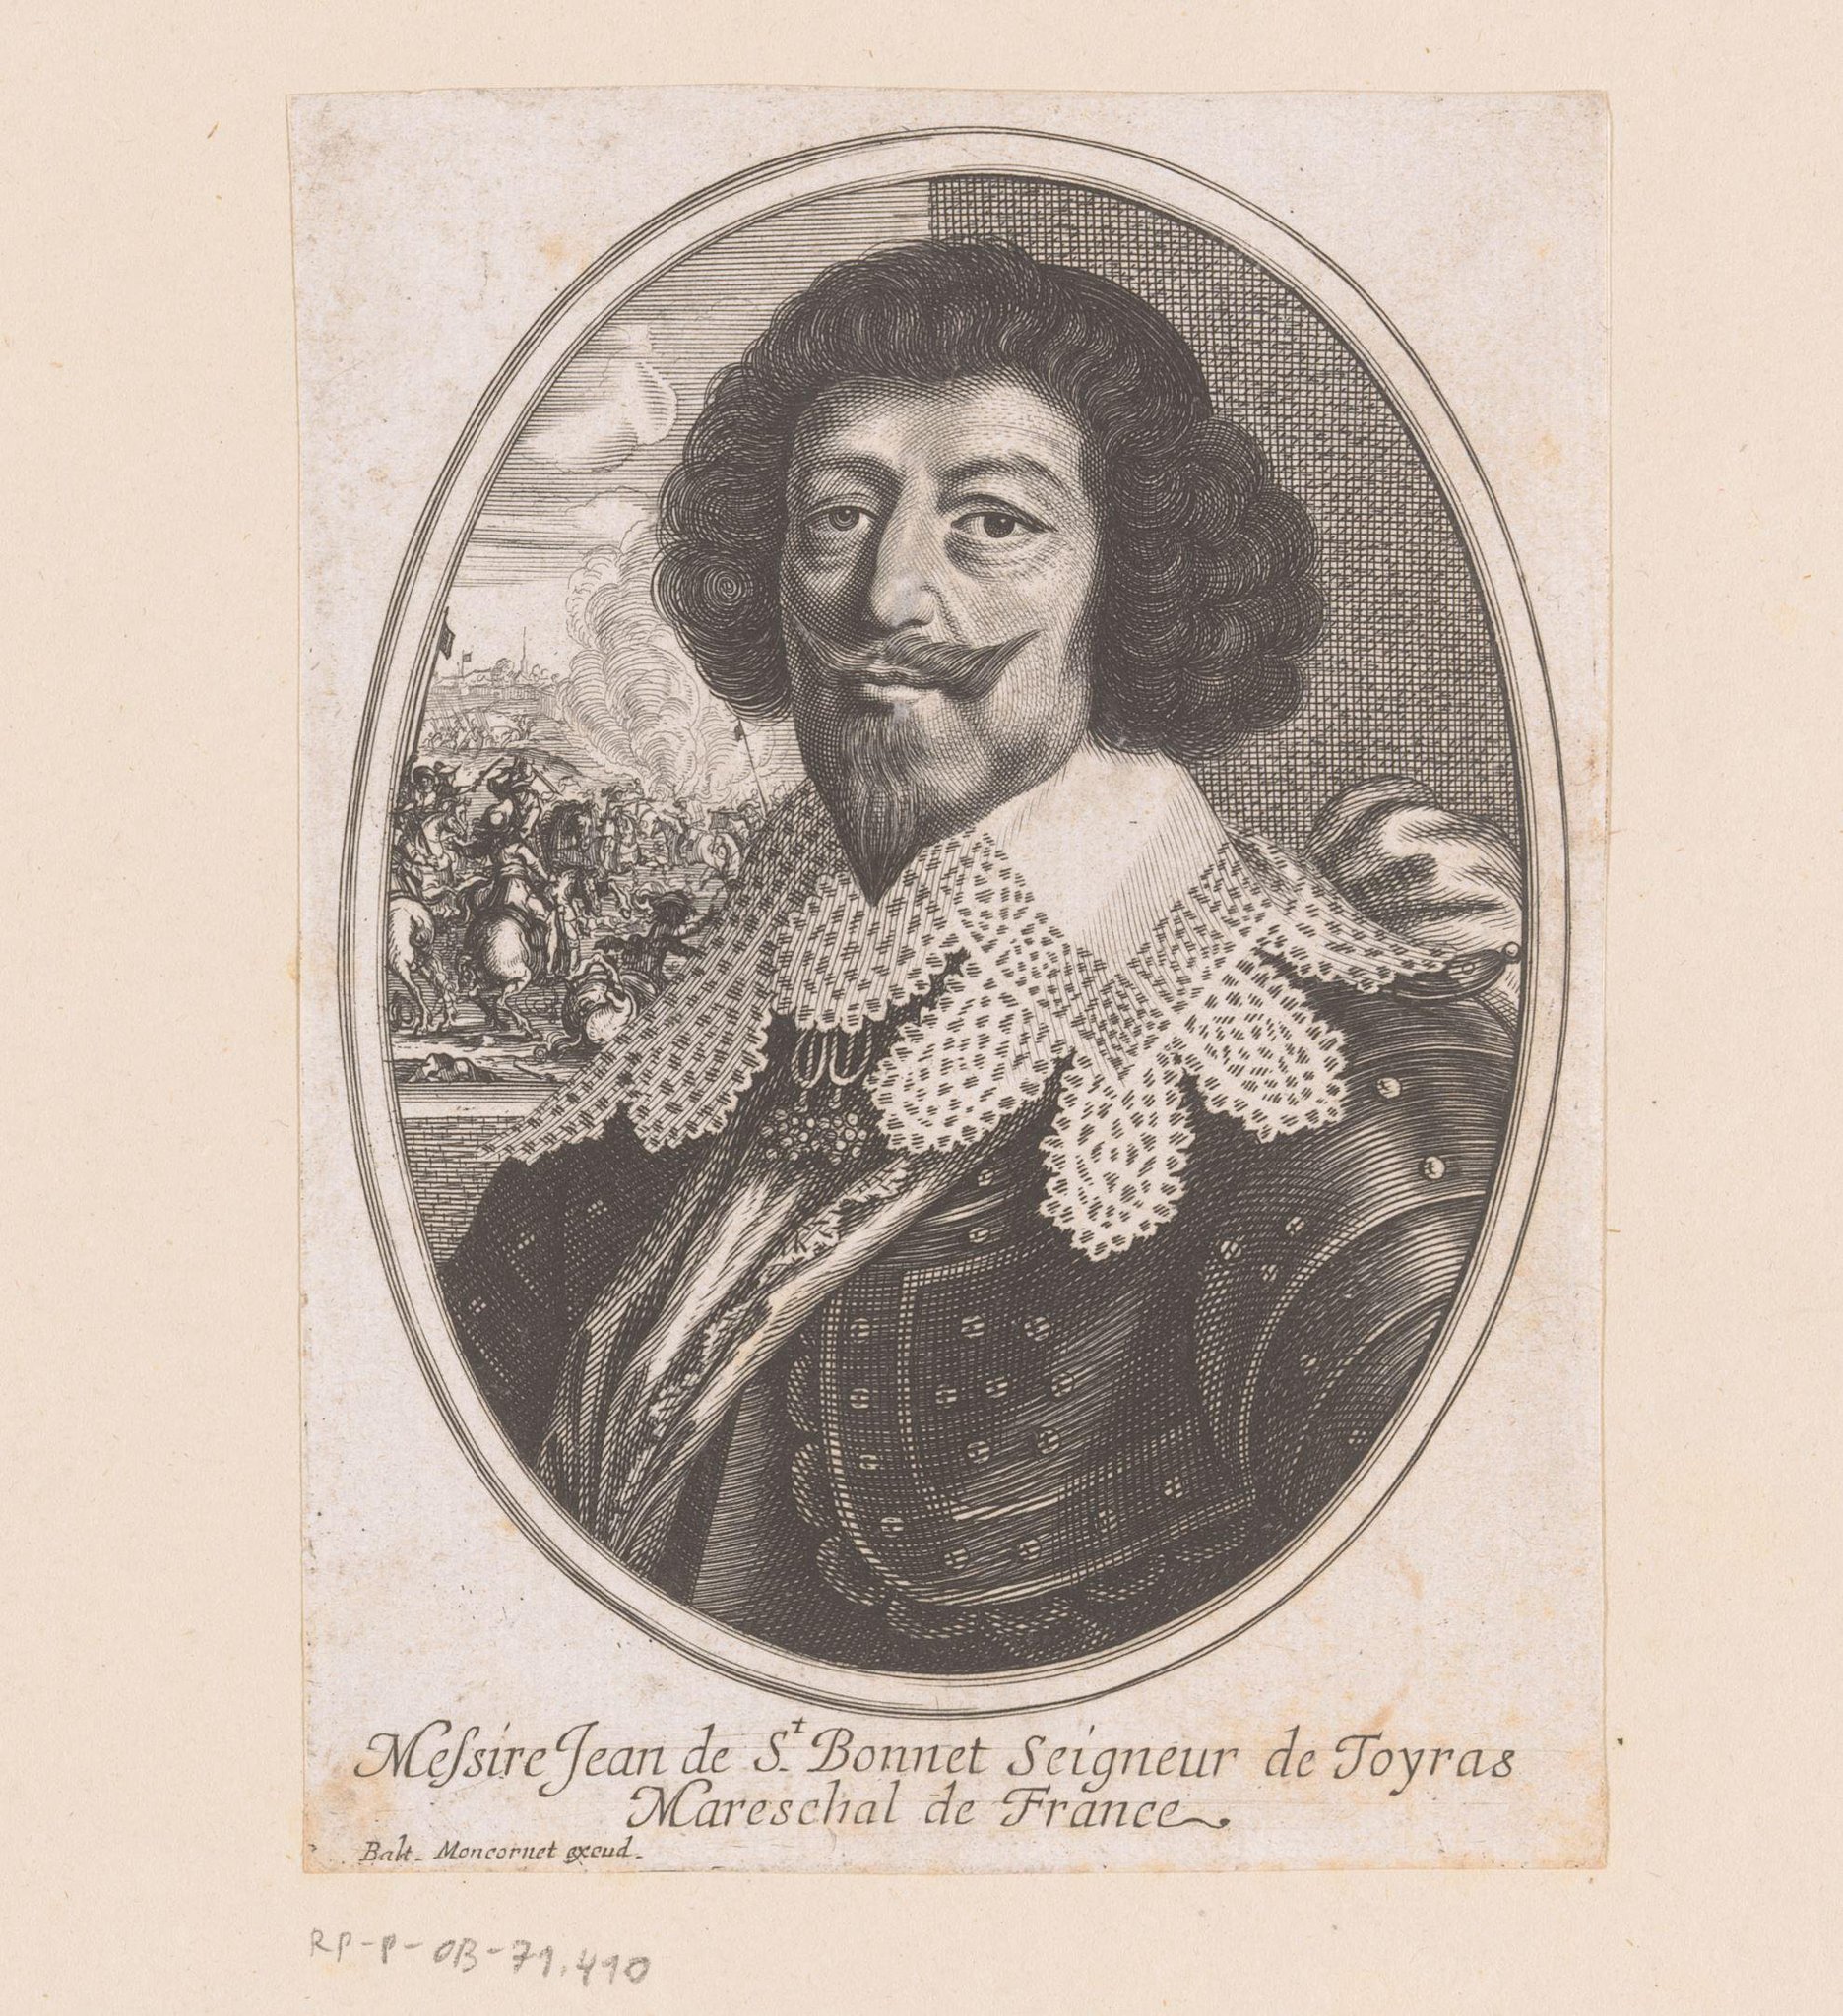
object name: print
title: Portret van Jean Caylar d'Anduze de Saint-Bonnet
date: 1610-1668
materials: paper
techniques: engraving, etching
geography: paris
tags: commander-in-chief, general, marshal, historical persons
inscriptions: collector's mark: Lugt 240